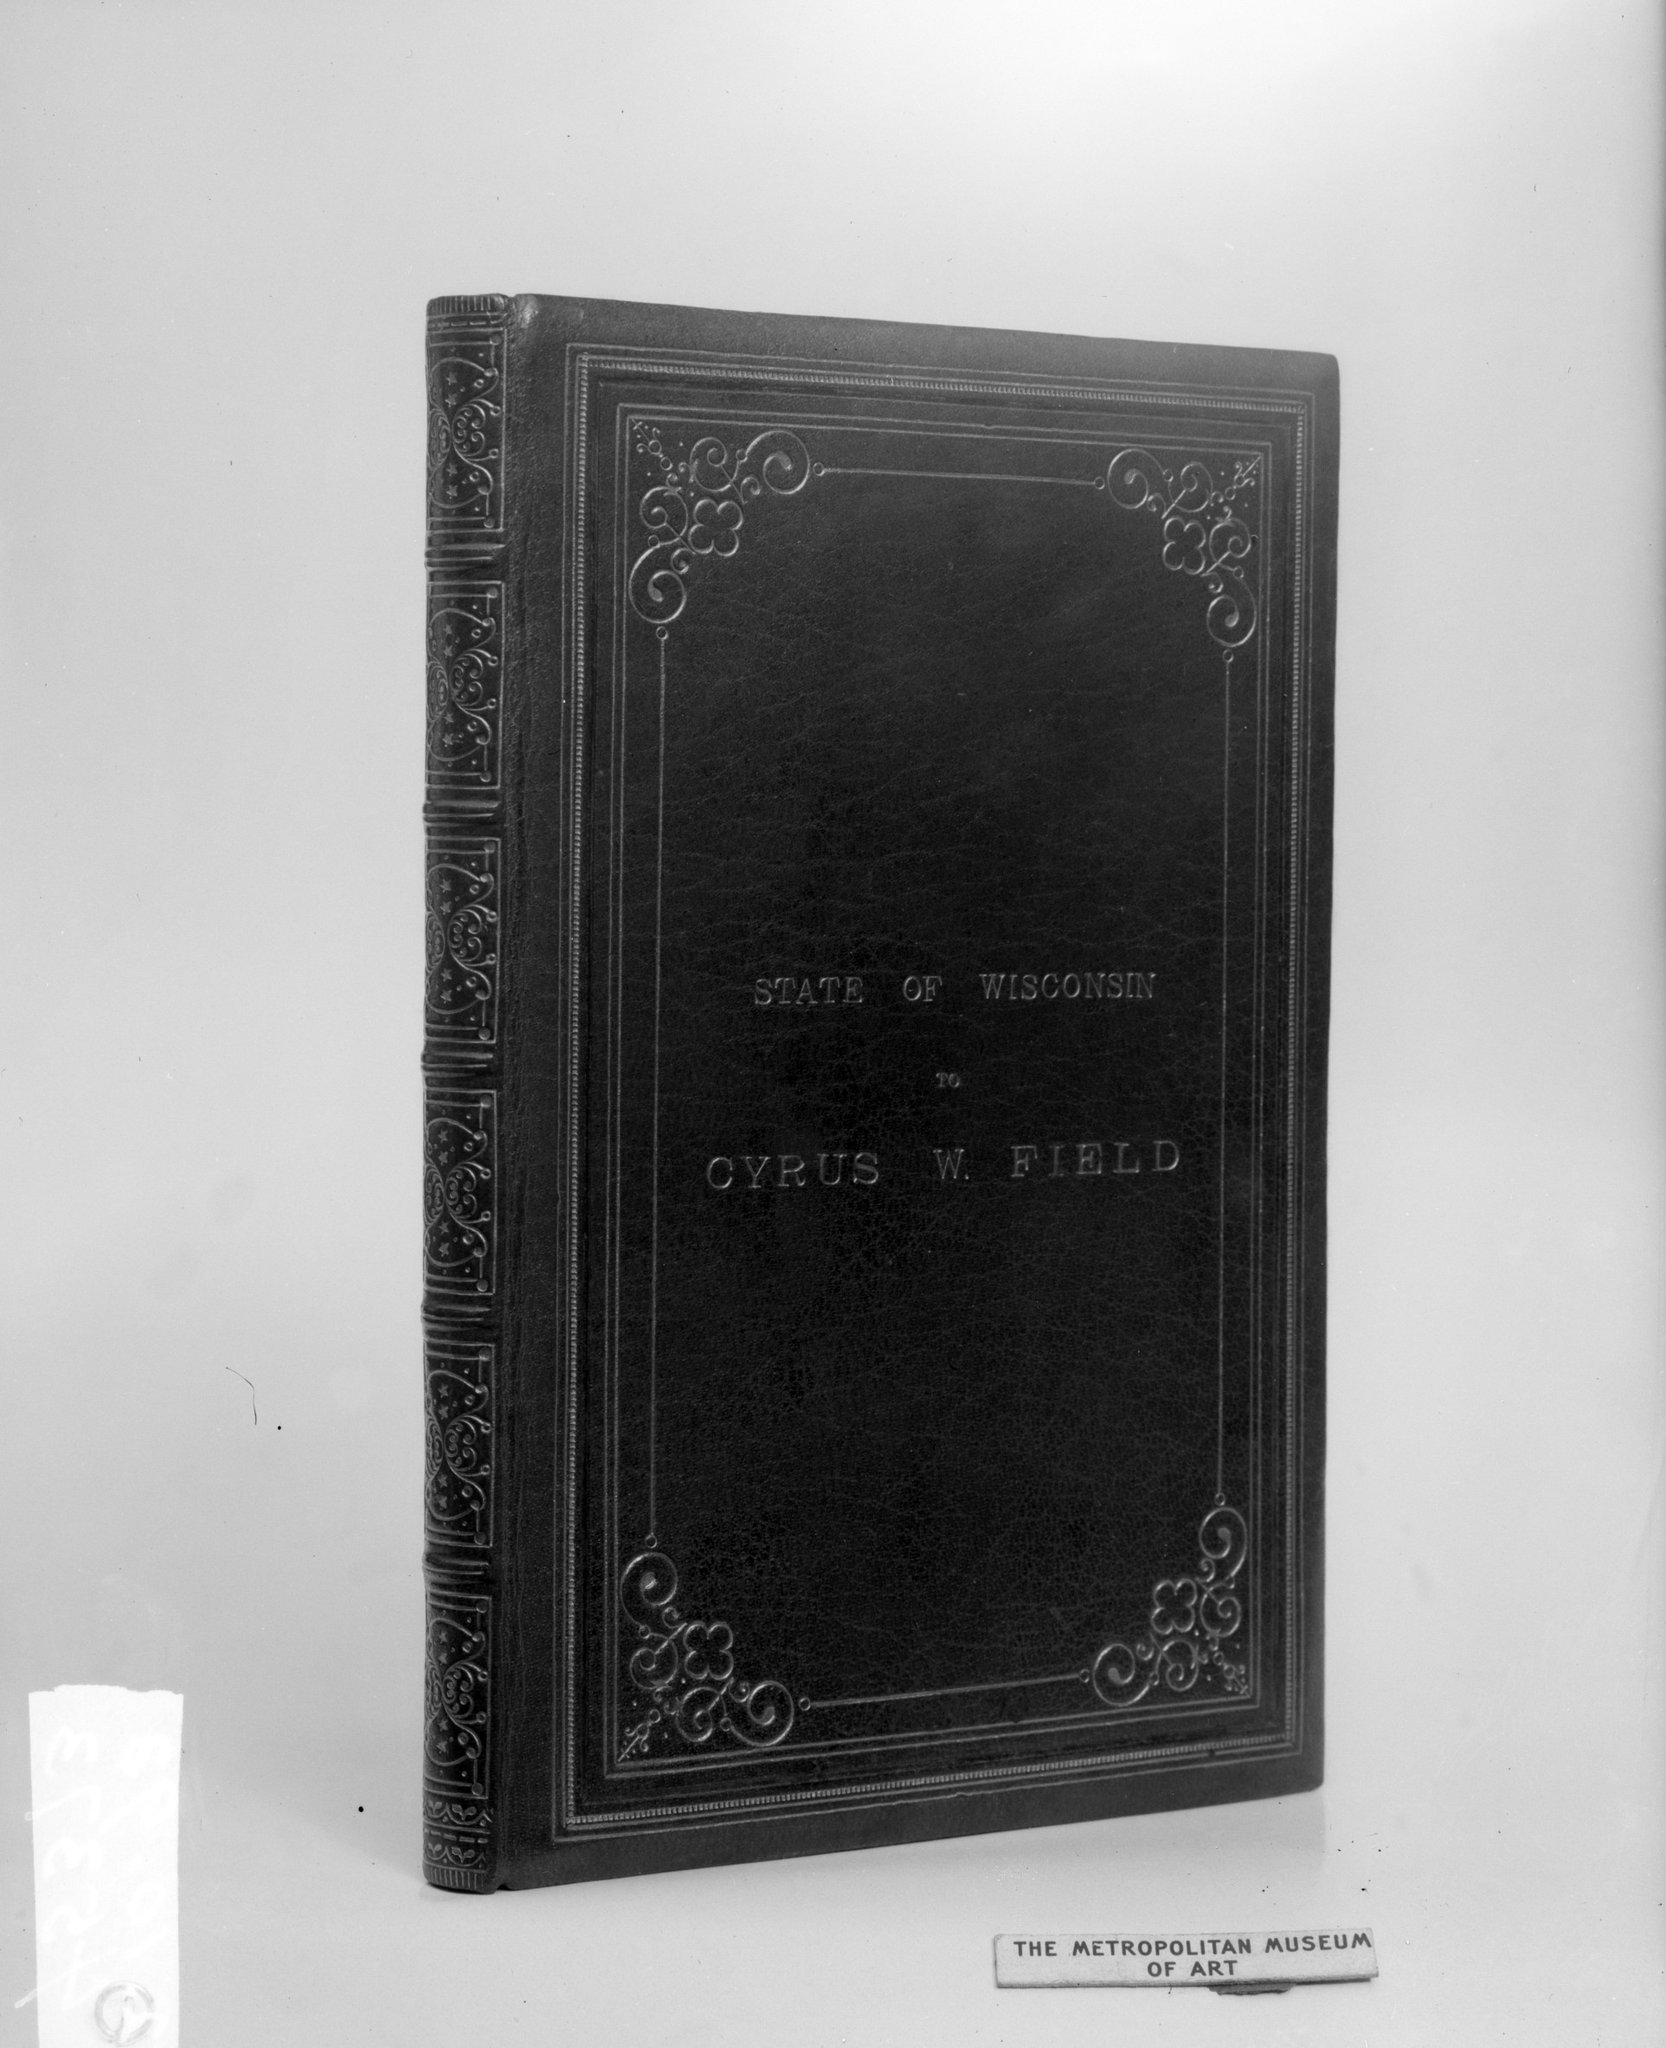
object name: manuscript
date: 1800-1892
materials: parchment